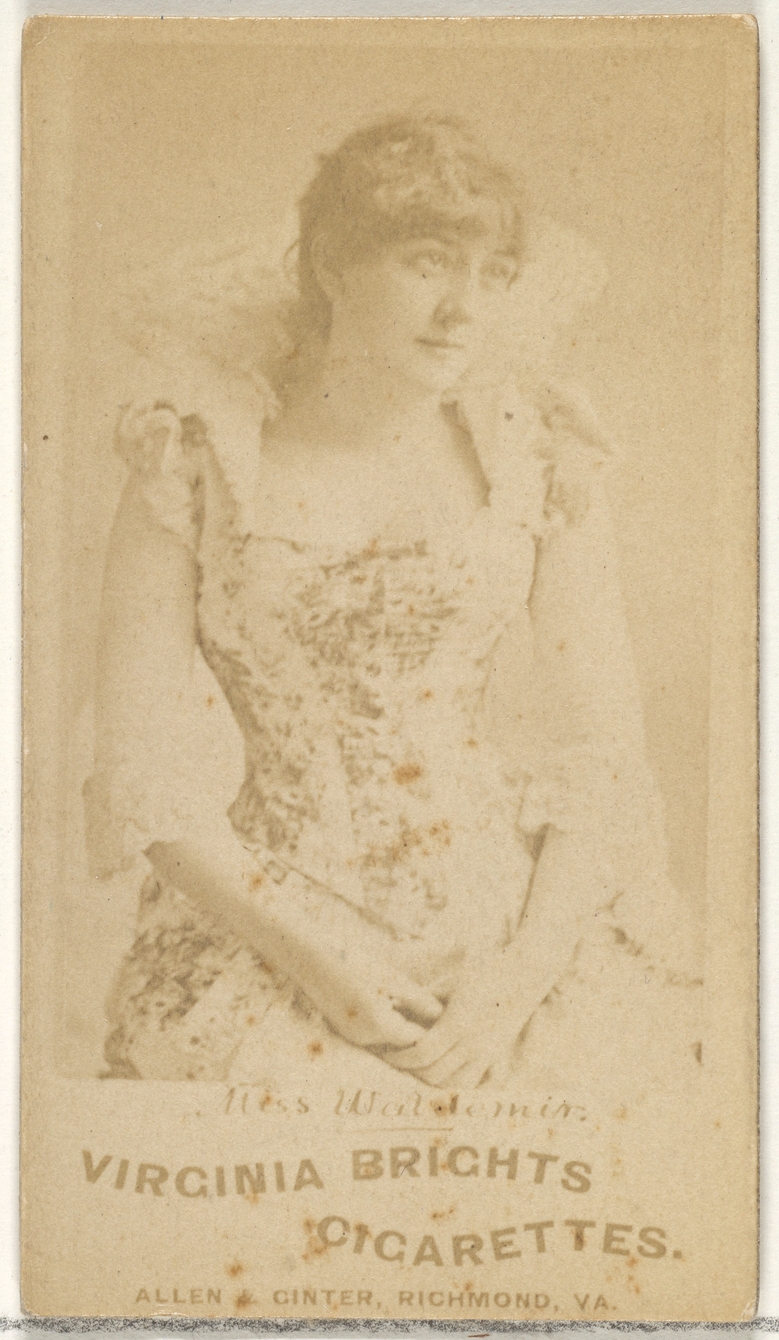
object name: photograph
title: Miss Waldimin, from the Actors and Actresses series (N45, Type 1) for Virginia Brights Cigarettes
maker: allen & ginter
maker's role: publisher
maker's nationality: american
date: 1888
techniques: albumen silver print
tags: portraits,women,actresses